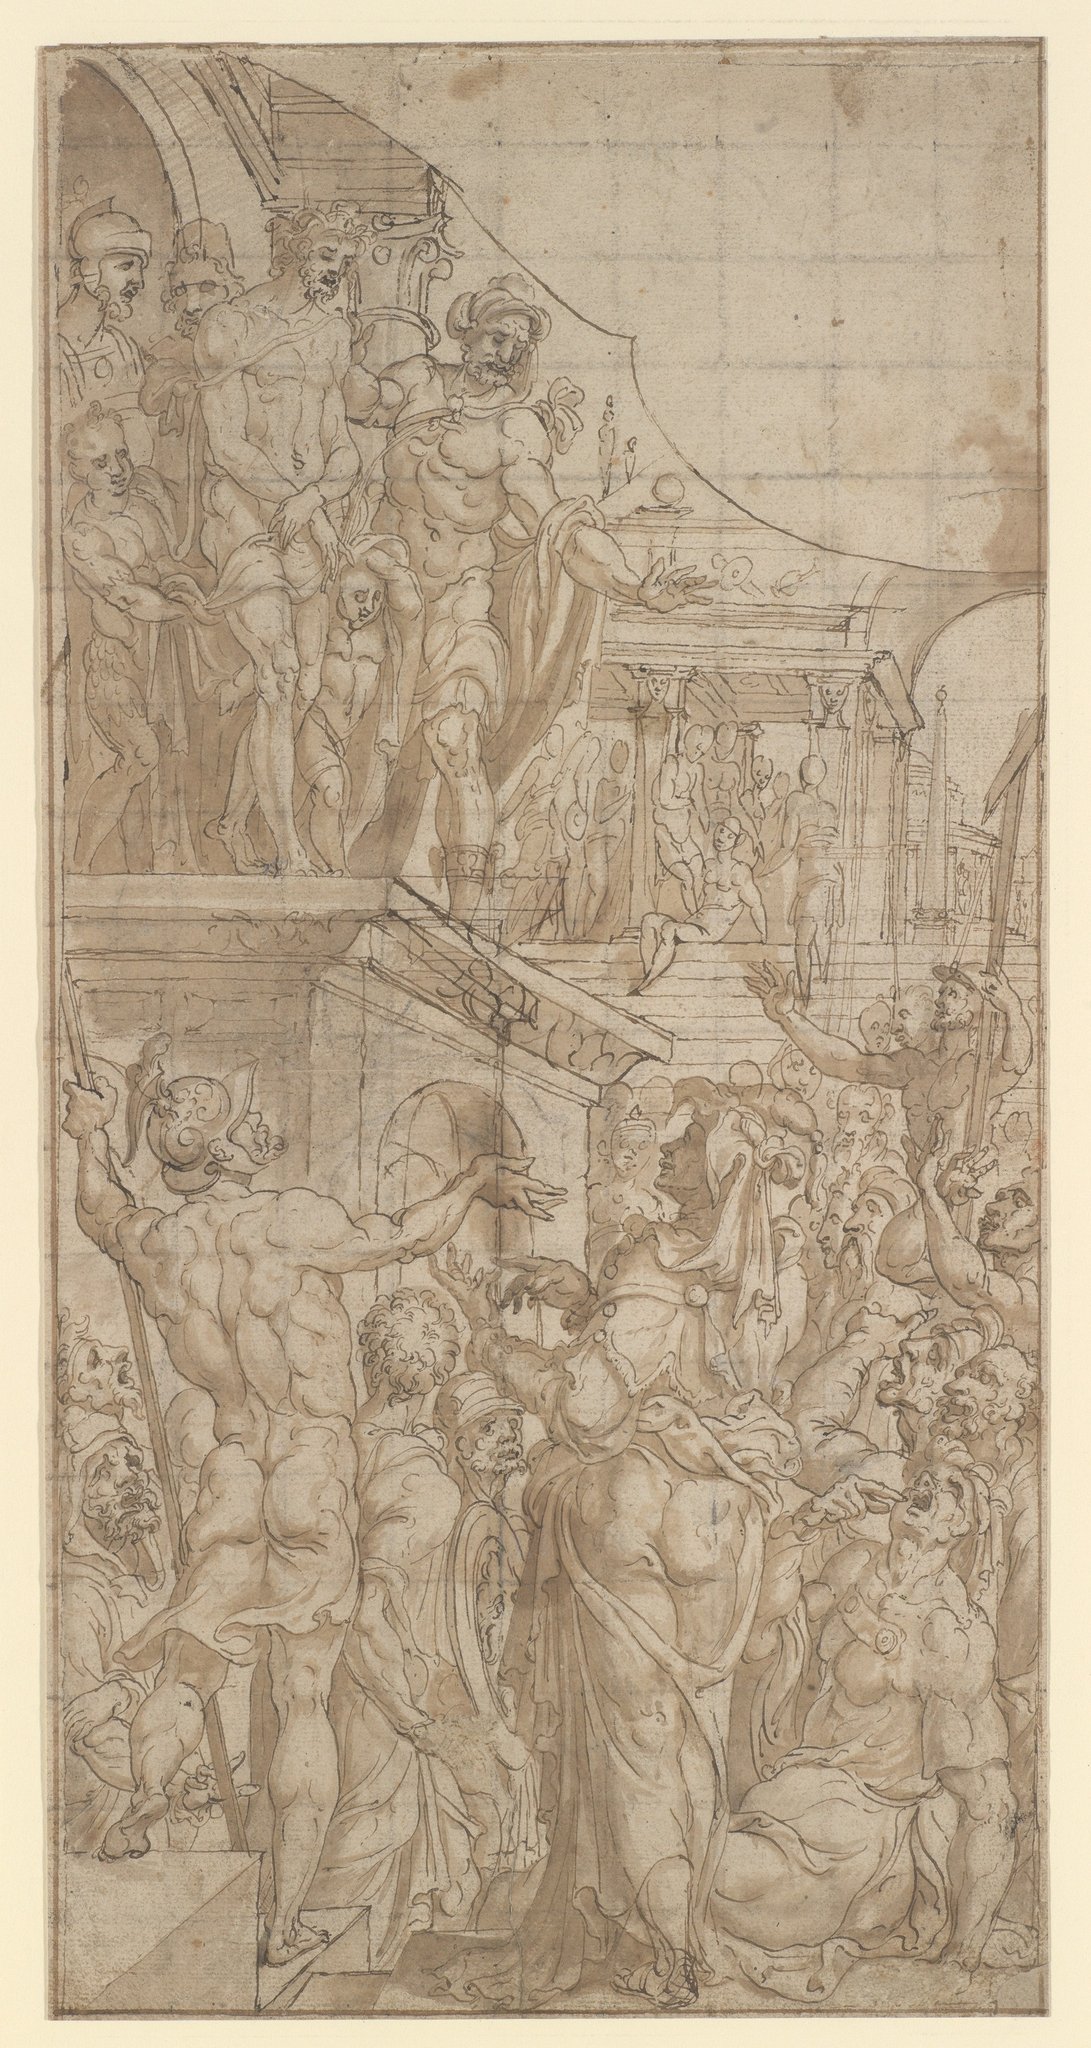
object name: drawing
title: Ecce Homo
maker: maarten van heemskerck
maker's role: artist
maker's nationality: netherlandish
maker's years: 1498-1574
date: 1501-1600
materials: chalk, ink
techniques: brush, pen, drawing, wash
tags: male nudes,christ